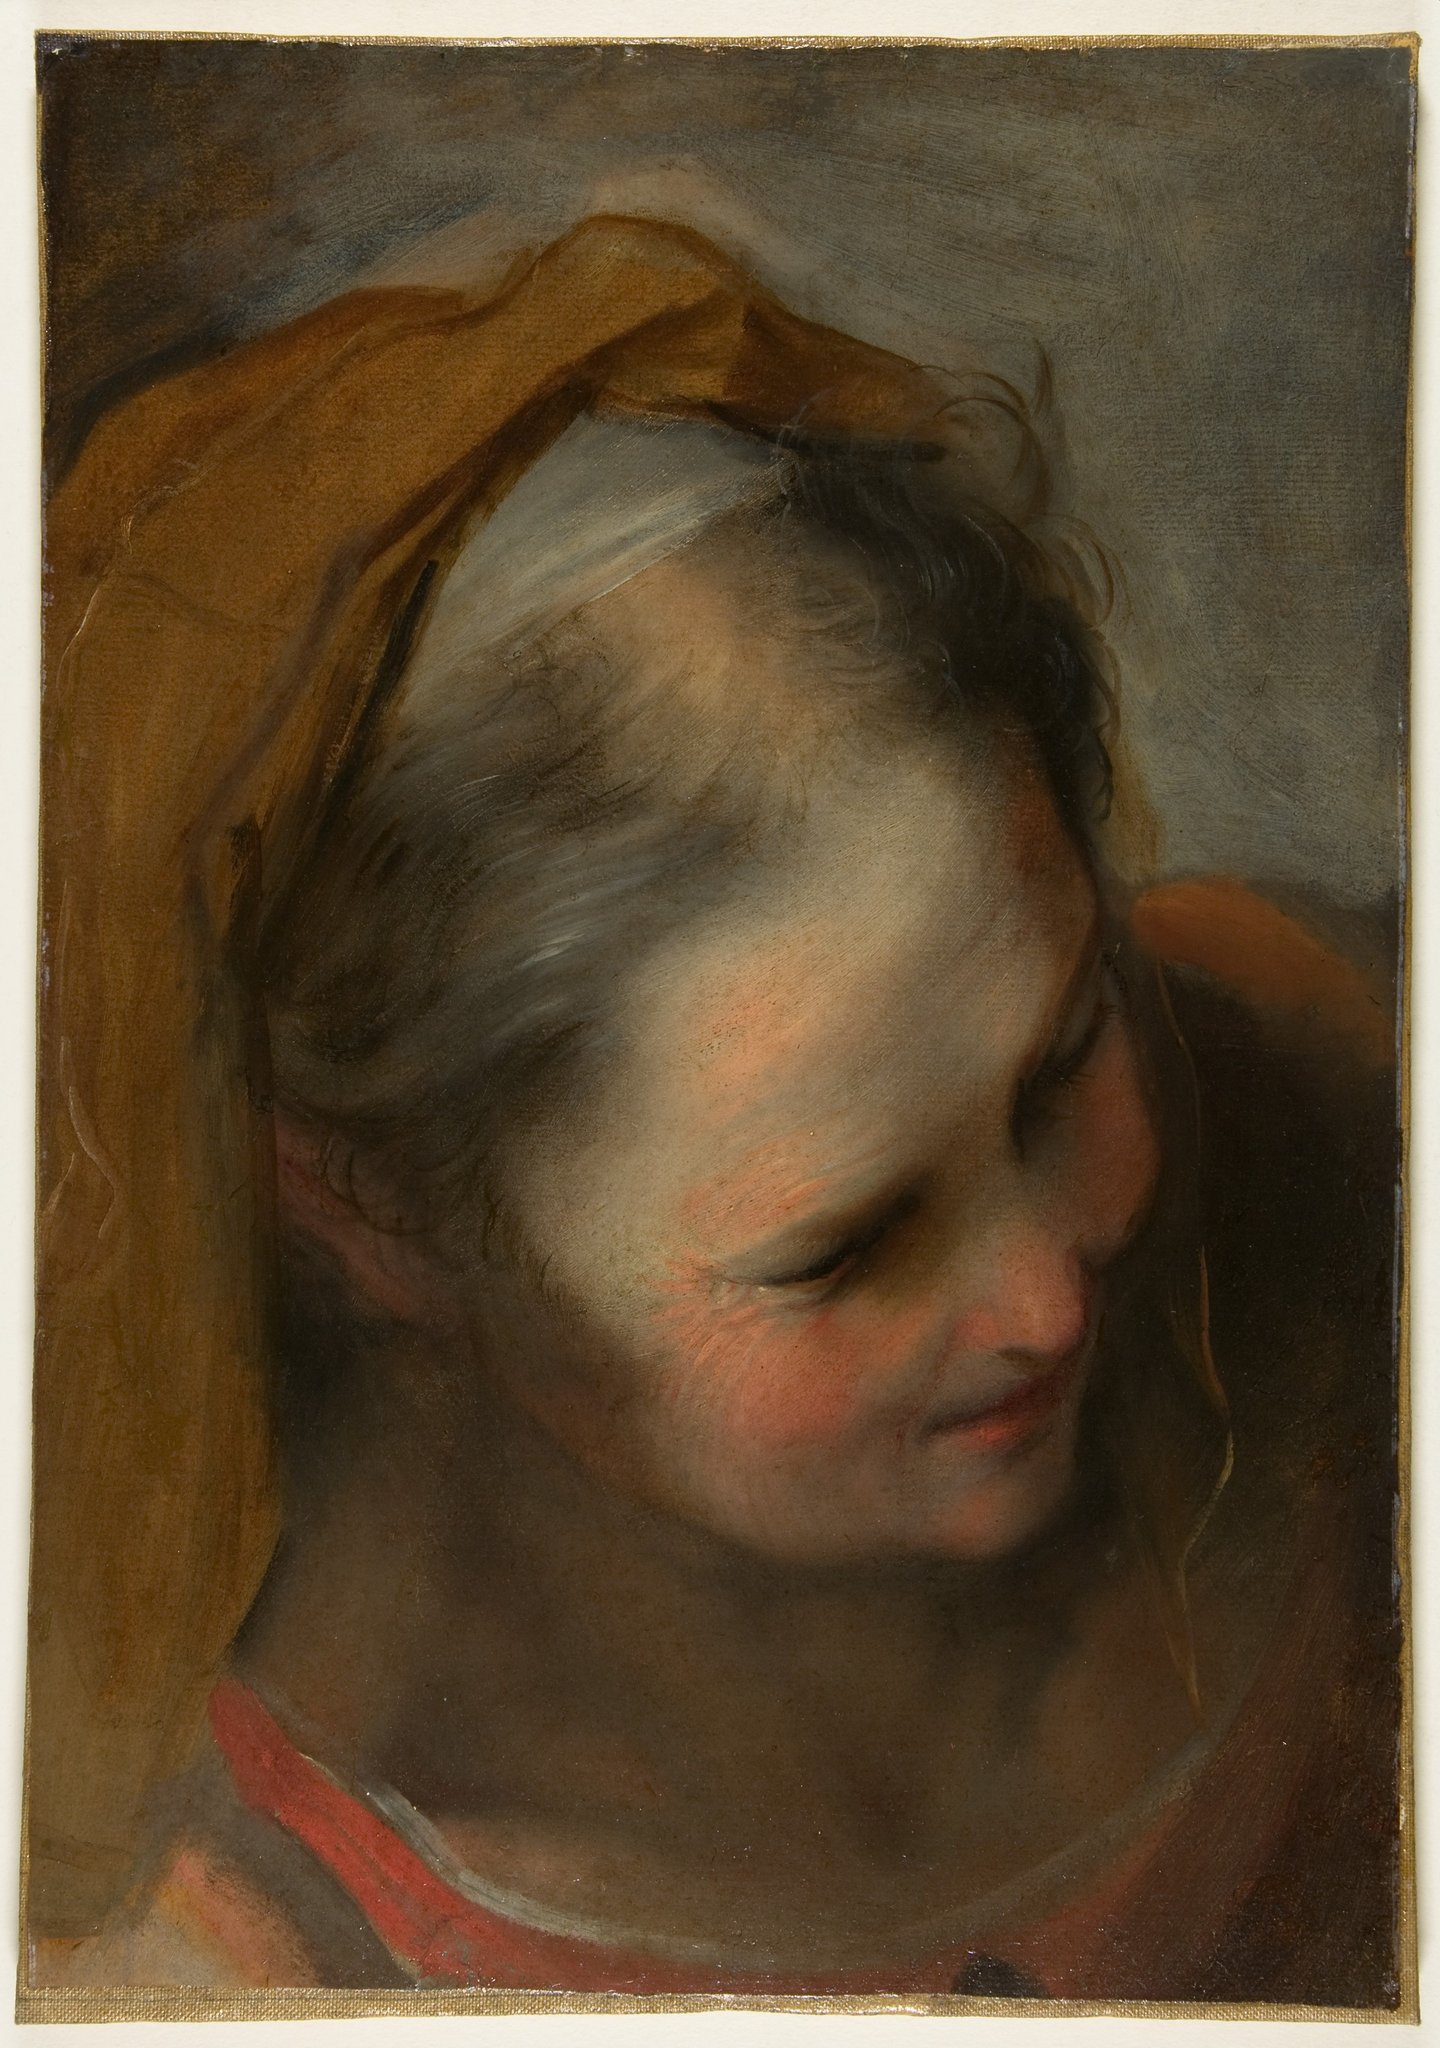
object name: drawing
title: Head of an Old Woman Looking to Lower Right (Saint Elizabeth)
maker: federico barocci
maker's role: artist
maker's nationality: italian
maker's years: 1535-1612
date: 1584-1586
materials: oil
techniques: brush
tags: heads,women